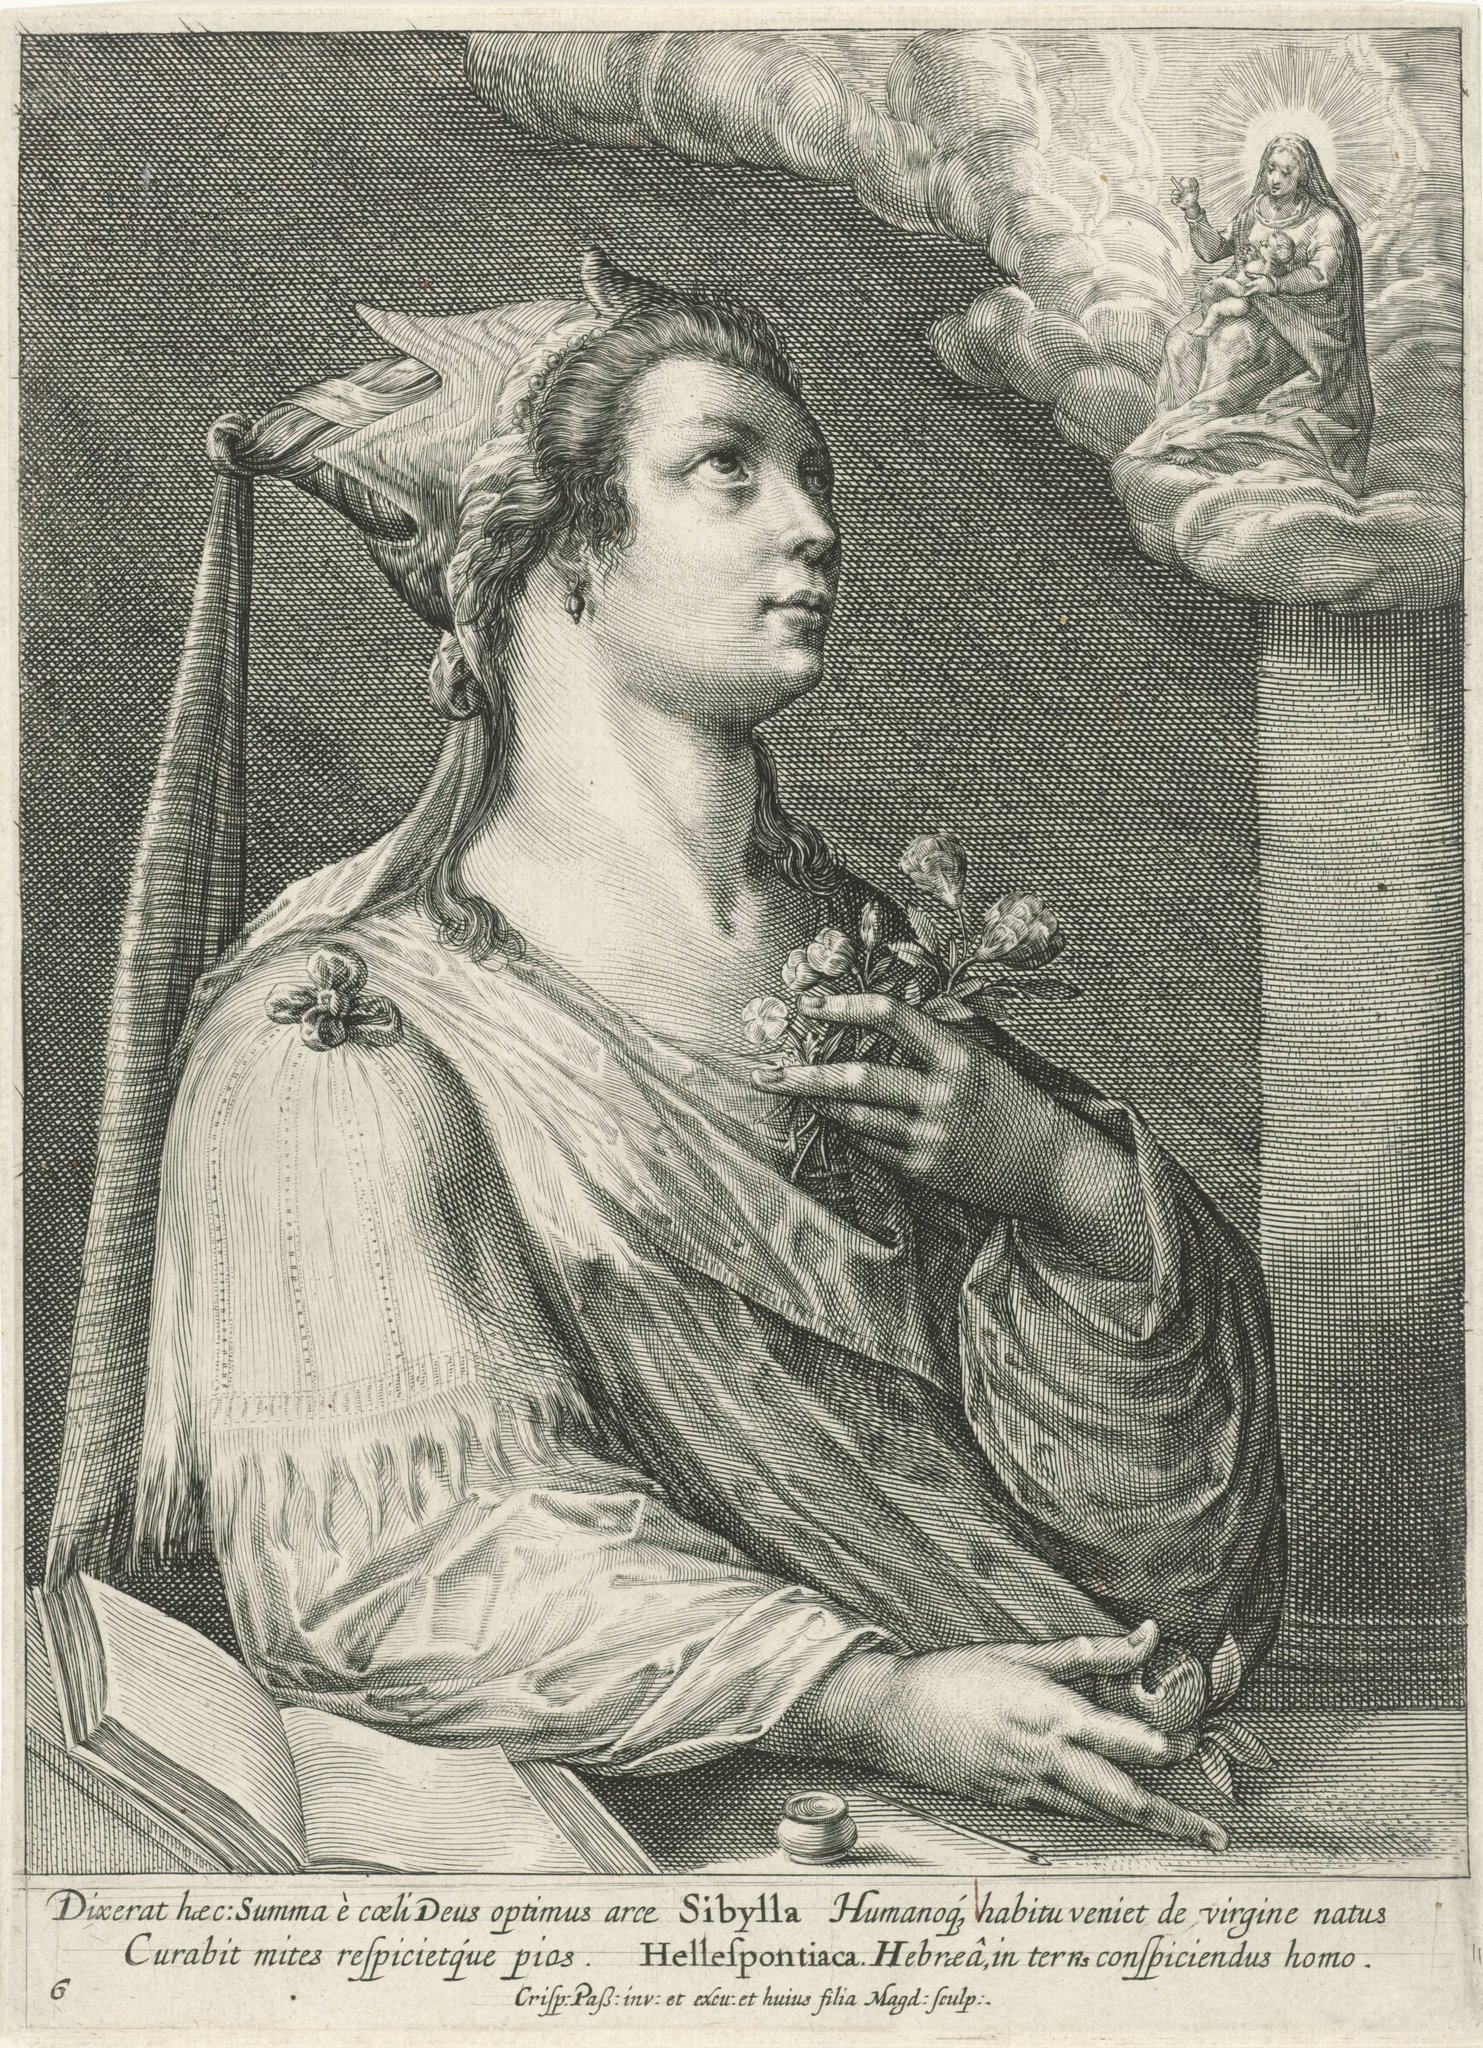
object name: print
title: Hellespontine Sybil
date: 1615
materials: paper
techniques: engraving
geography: utrecht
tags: madonna: mary sitting or enthroned, the christ-child in her lap (or in front of her bosom) (mary sometimes represented half-length), sibyls (with name)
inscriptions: collector's mark: Lugt 240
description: These four women in antique dress are sibyls: prophetesses who, according to tradition, announced the coming of Christ. The entire De Passe family workshop collaborated on the series, which consisted of twelve prints. This teamwork enabled the shop to produce large quantities of prints at a fast pace. Magdalena was responsible for these three sibyls.